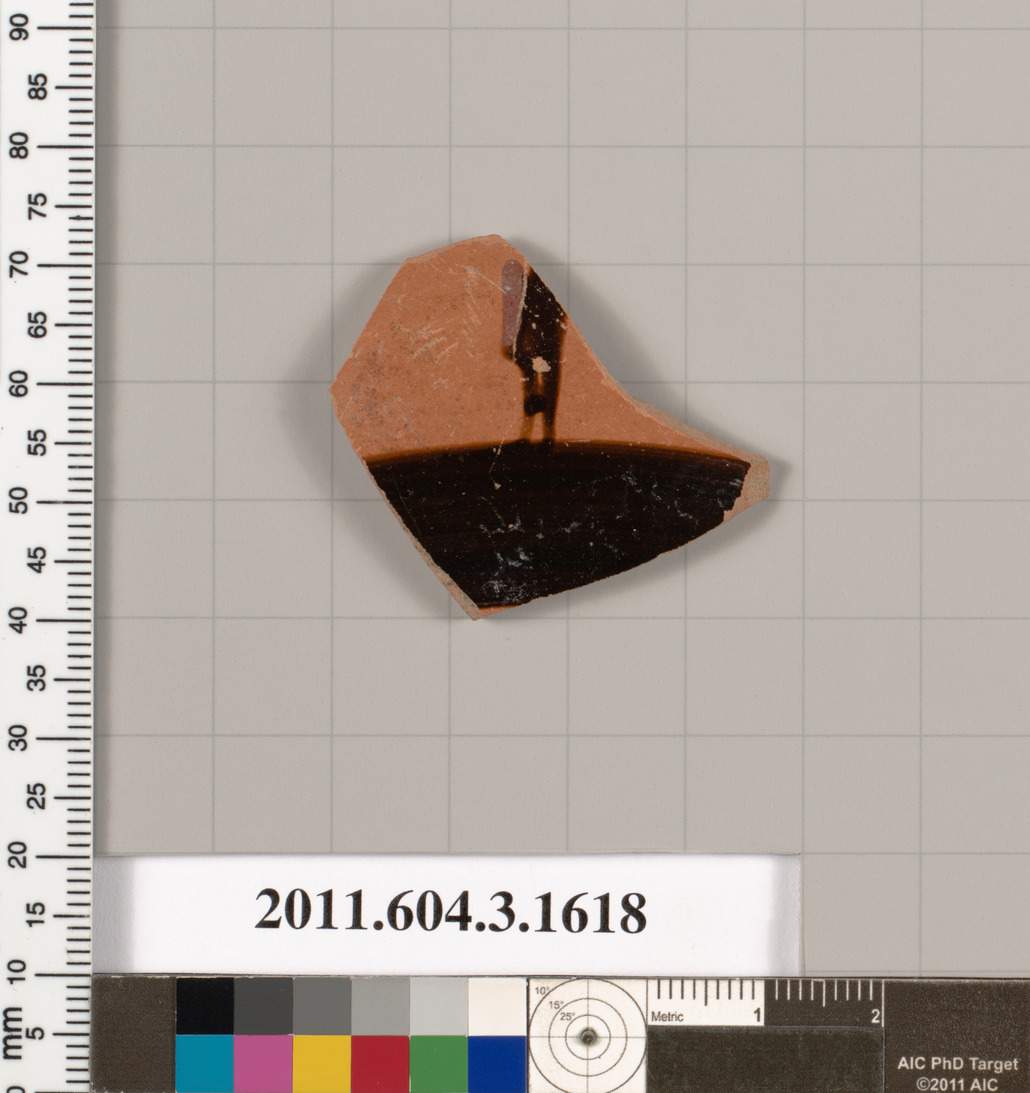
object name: kylix fragment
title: Terracotta fragment of a kylix: Band cup (drinking cup)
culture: greek, attic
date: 550-526 BCE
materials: terracotta